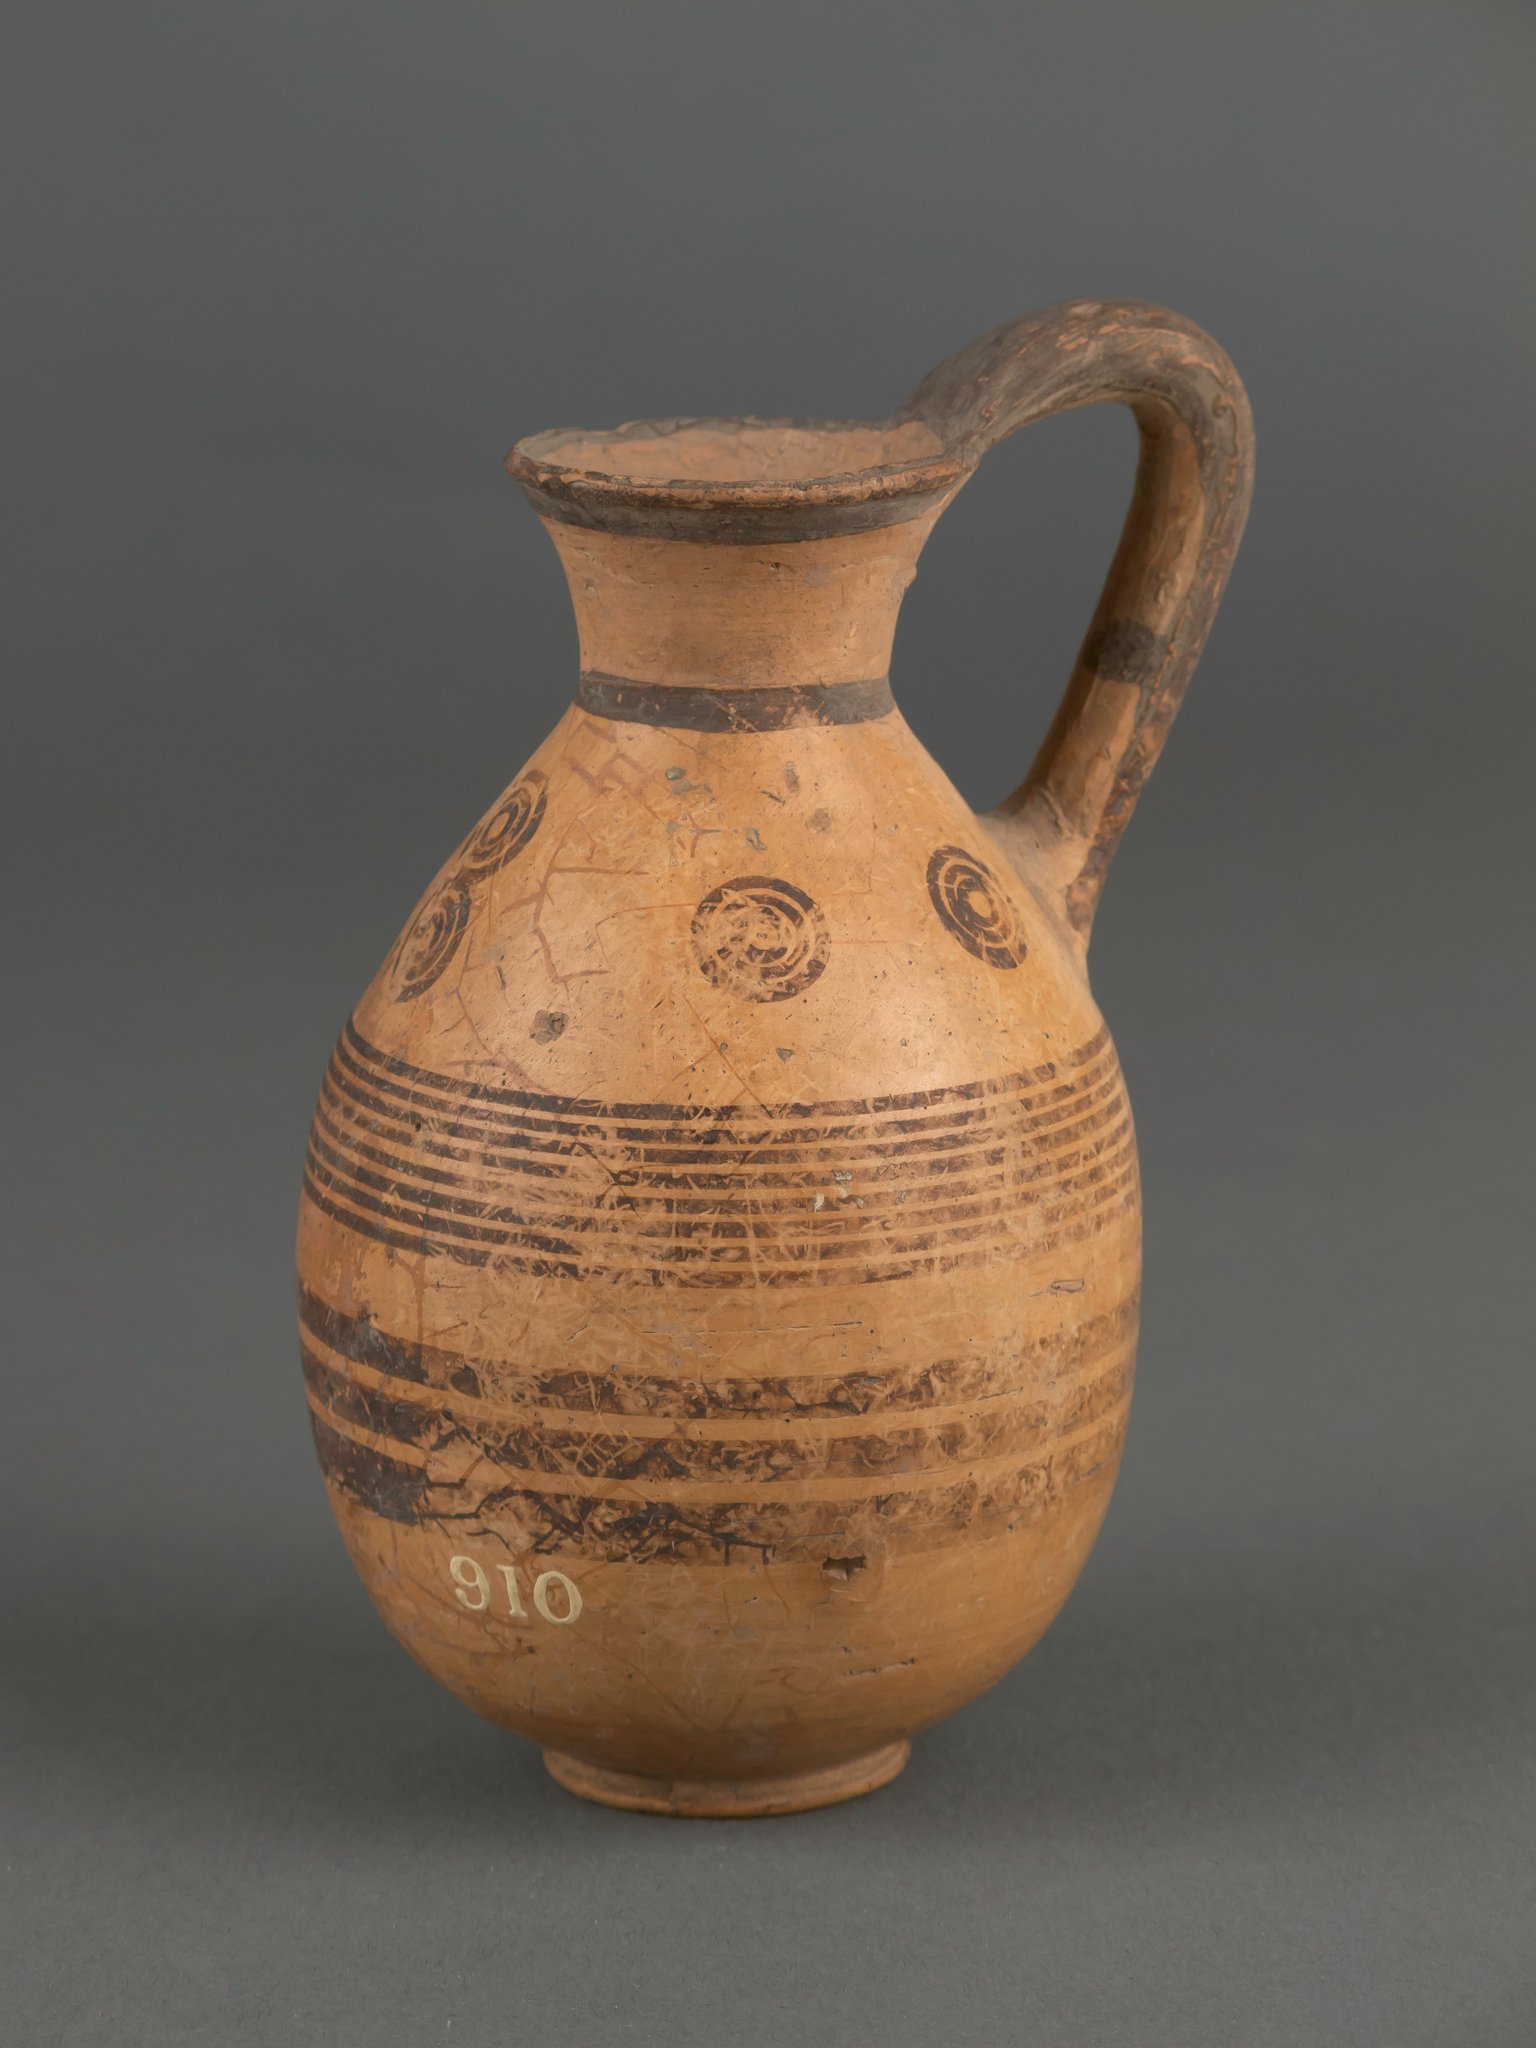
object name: juglet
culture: cypriot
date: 850-750 BCE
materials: terracotta